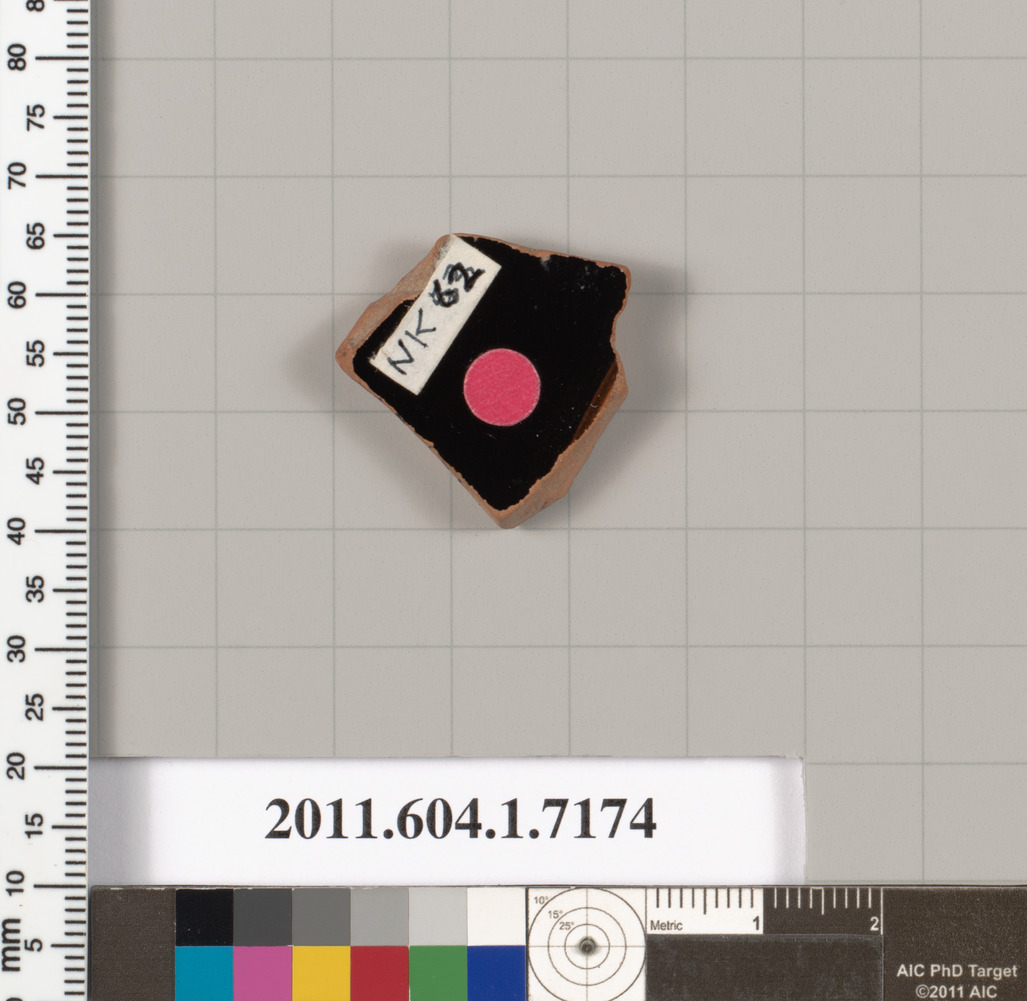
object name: kylix fragment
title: Terracotta fragment of a kylix (drinking cup)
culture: greek, attic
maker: makron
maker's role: artist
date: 500-480 BCE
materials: terracotta